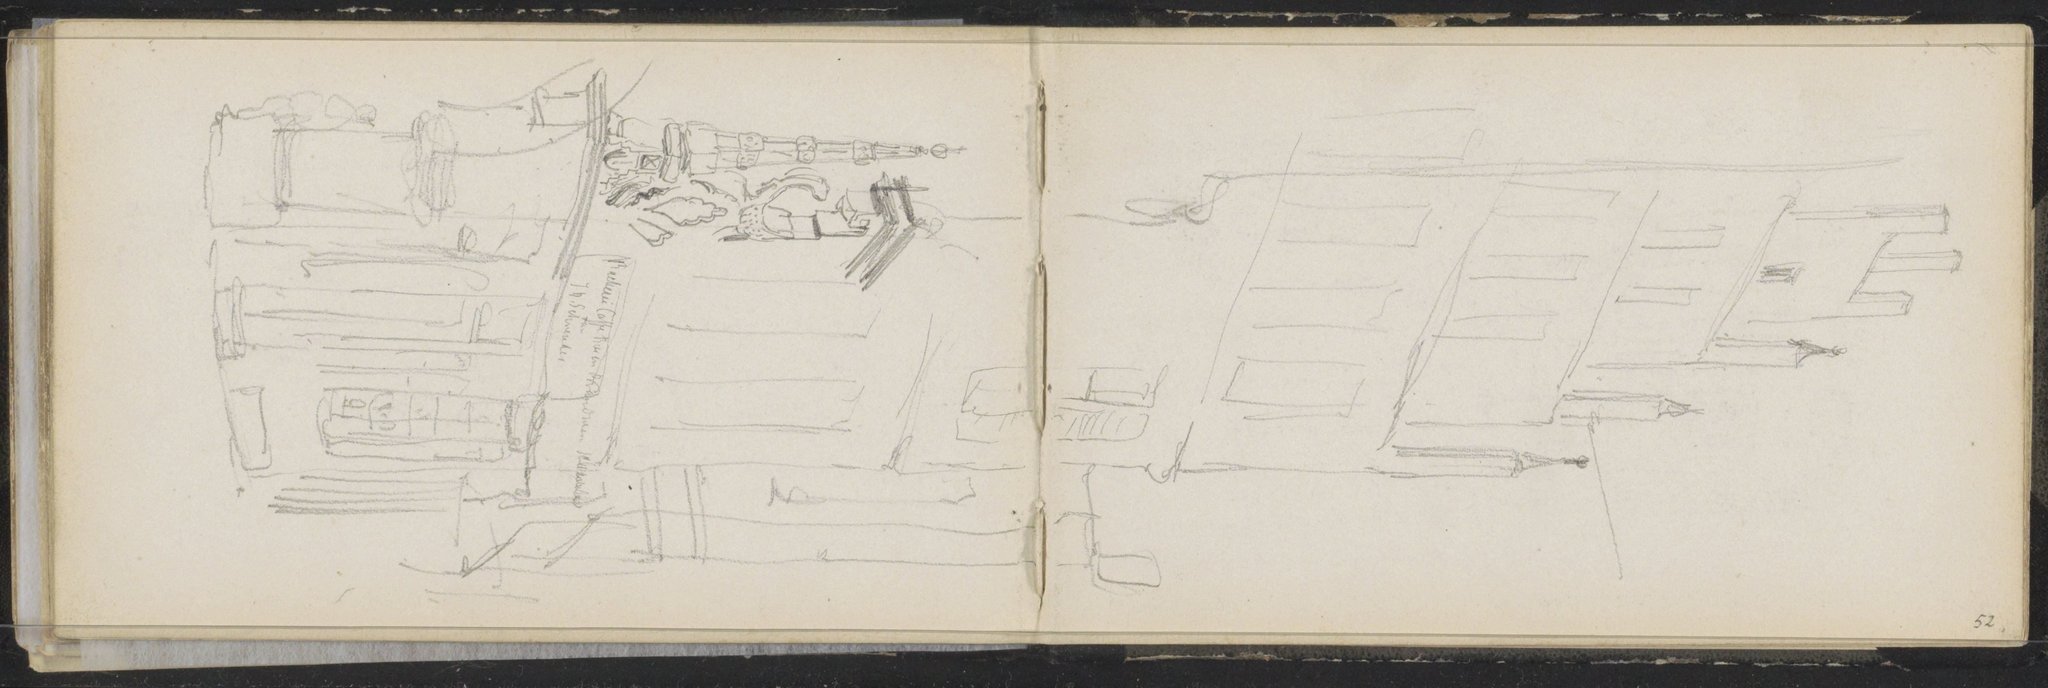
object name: sketchbook leaf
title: Gevel van een bakkerij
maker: cornelis springer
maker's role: draughtsman, painter, print maker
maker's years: 1817-1891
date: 1863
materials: paper, pencil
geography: north germany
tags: baker (+ place ~ crafts, industries, agriculture), front façade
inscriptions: inscription: ‘Backerei Caffe Bieren en [...]/ J.H. Schwenker[?]’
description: Gevel van een bakkerij. Blad 51 verso en blad 52 recto uit een schetsboek met 55 bladen vervaardigd op de Veluwe en in Noord-Duitsland.